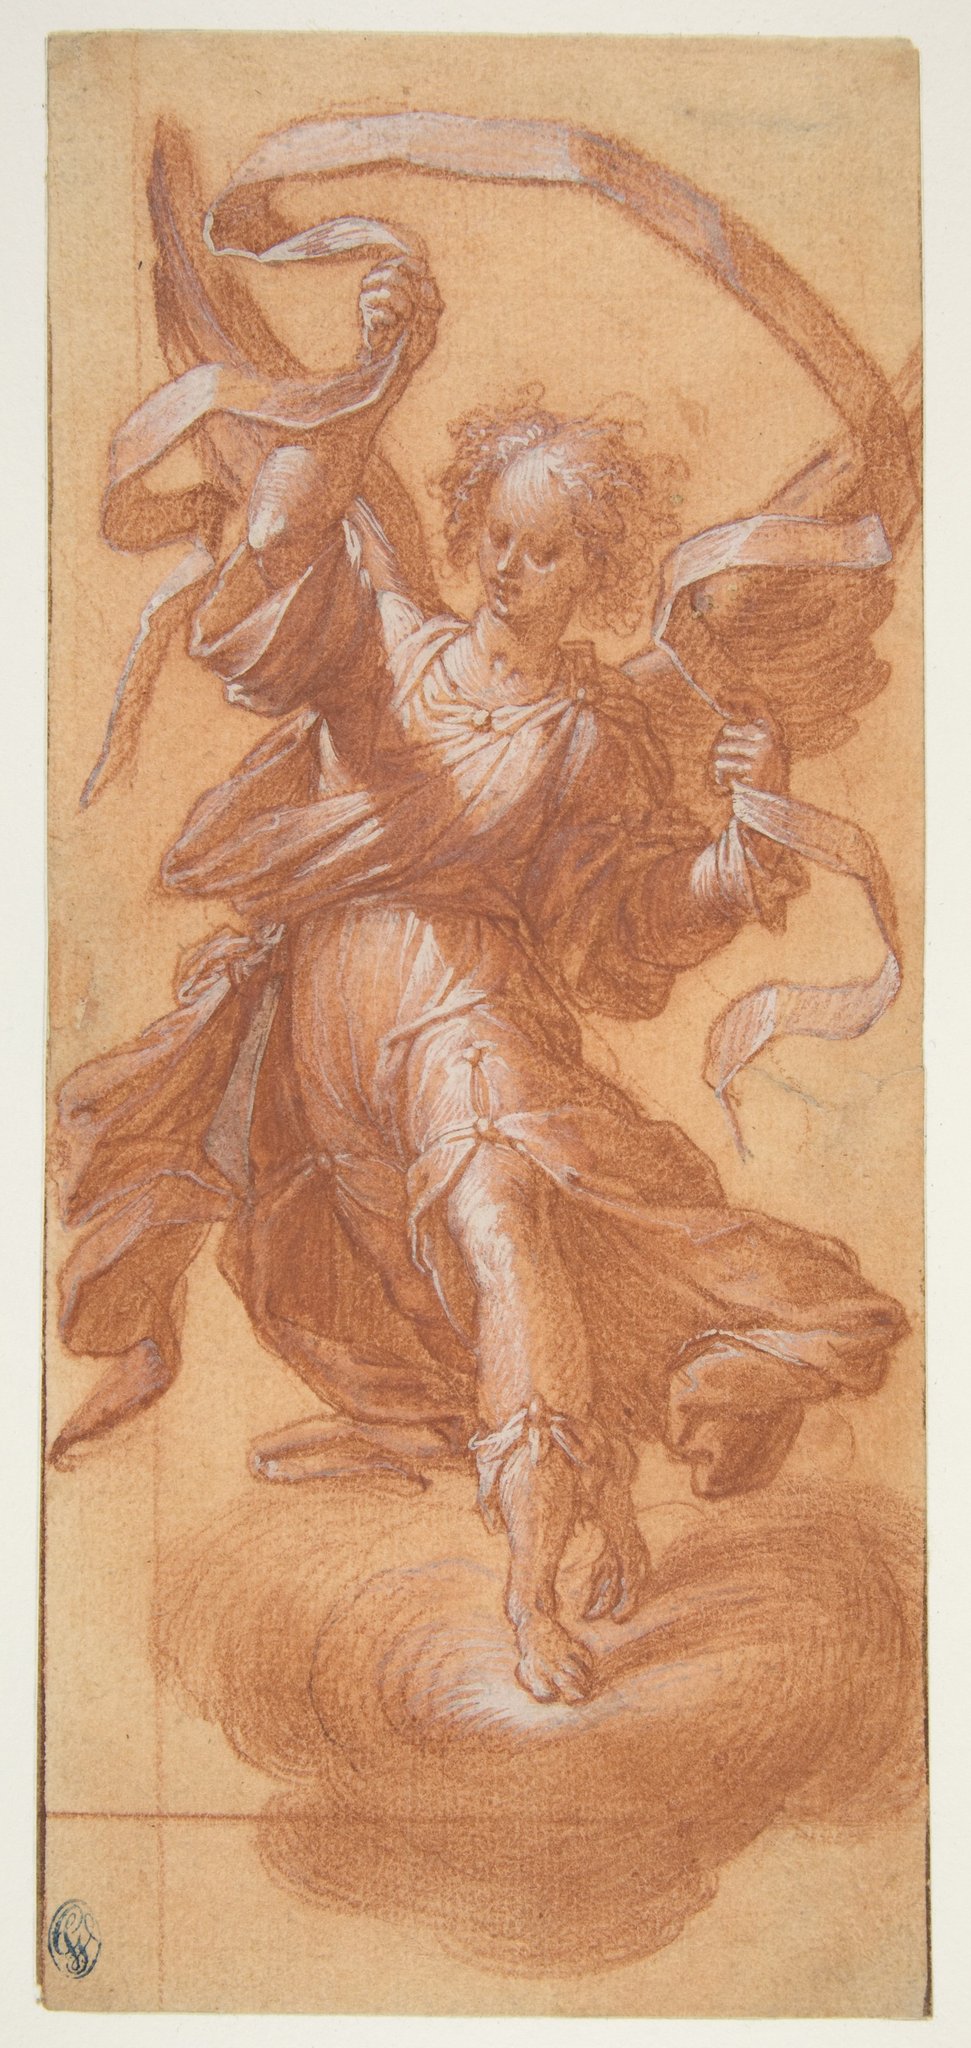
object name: drawing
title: Angel with a Banderole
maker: camillo procaccini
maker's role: artist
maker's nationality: italian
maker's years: 1555-1629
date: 1575-1629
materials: chalk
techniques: brush, highlighting, wash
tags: angels